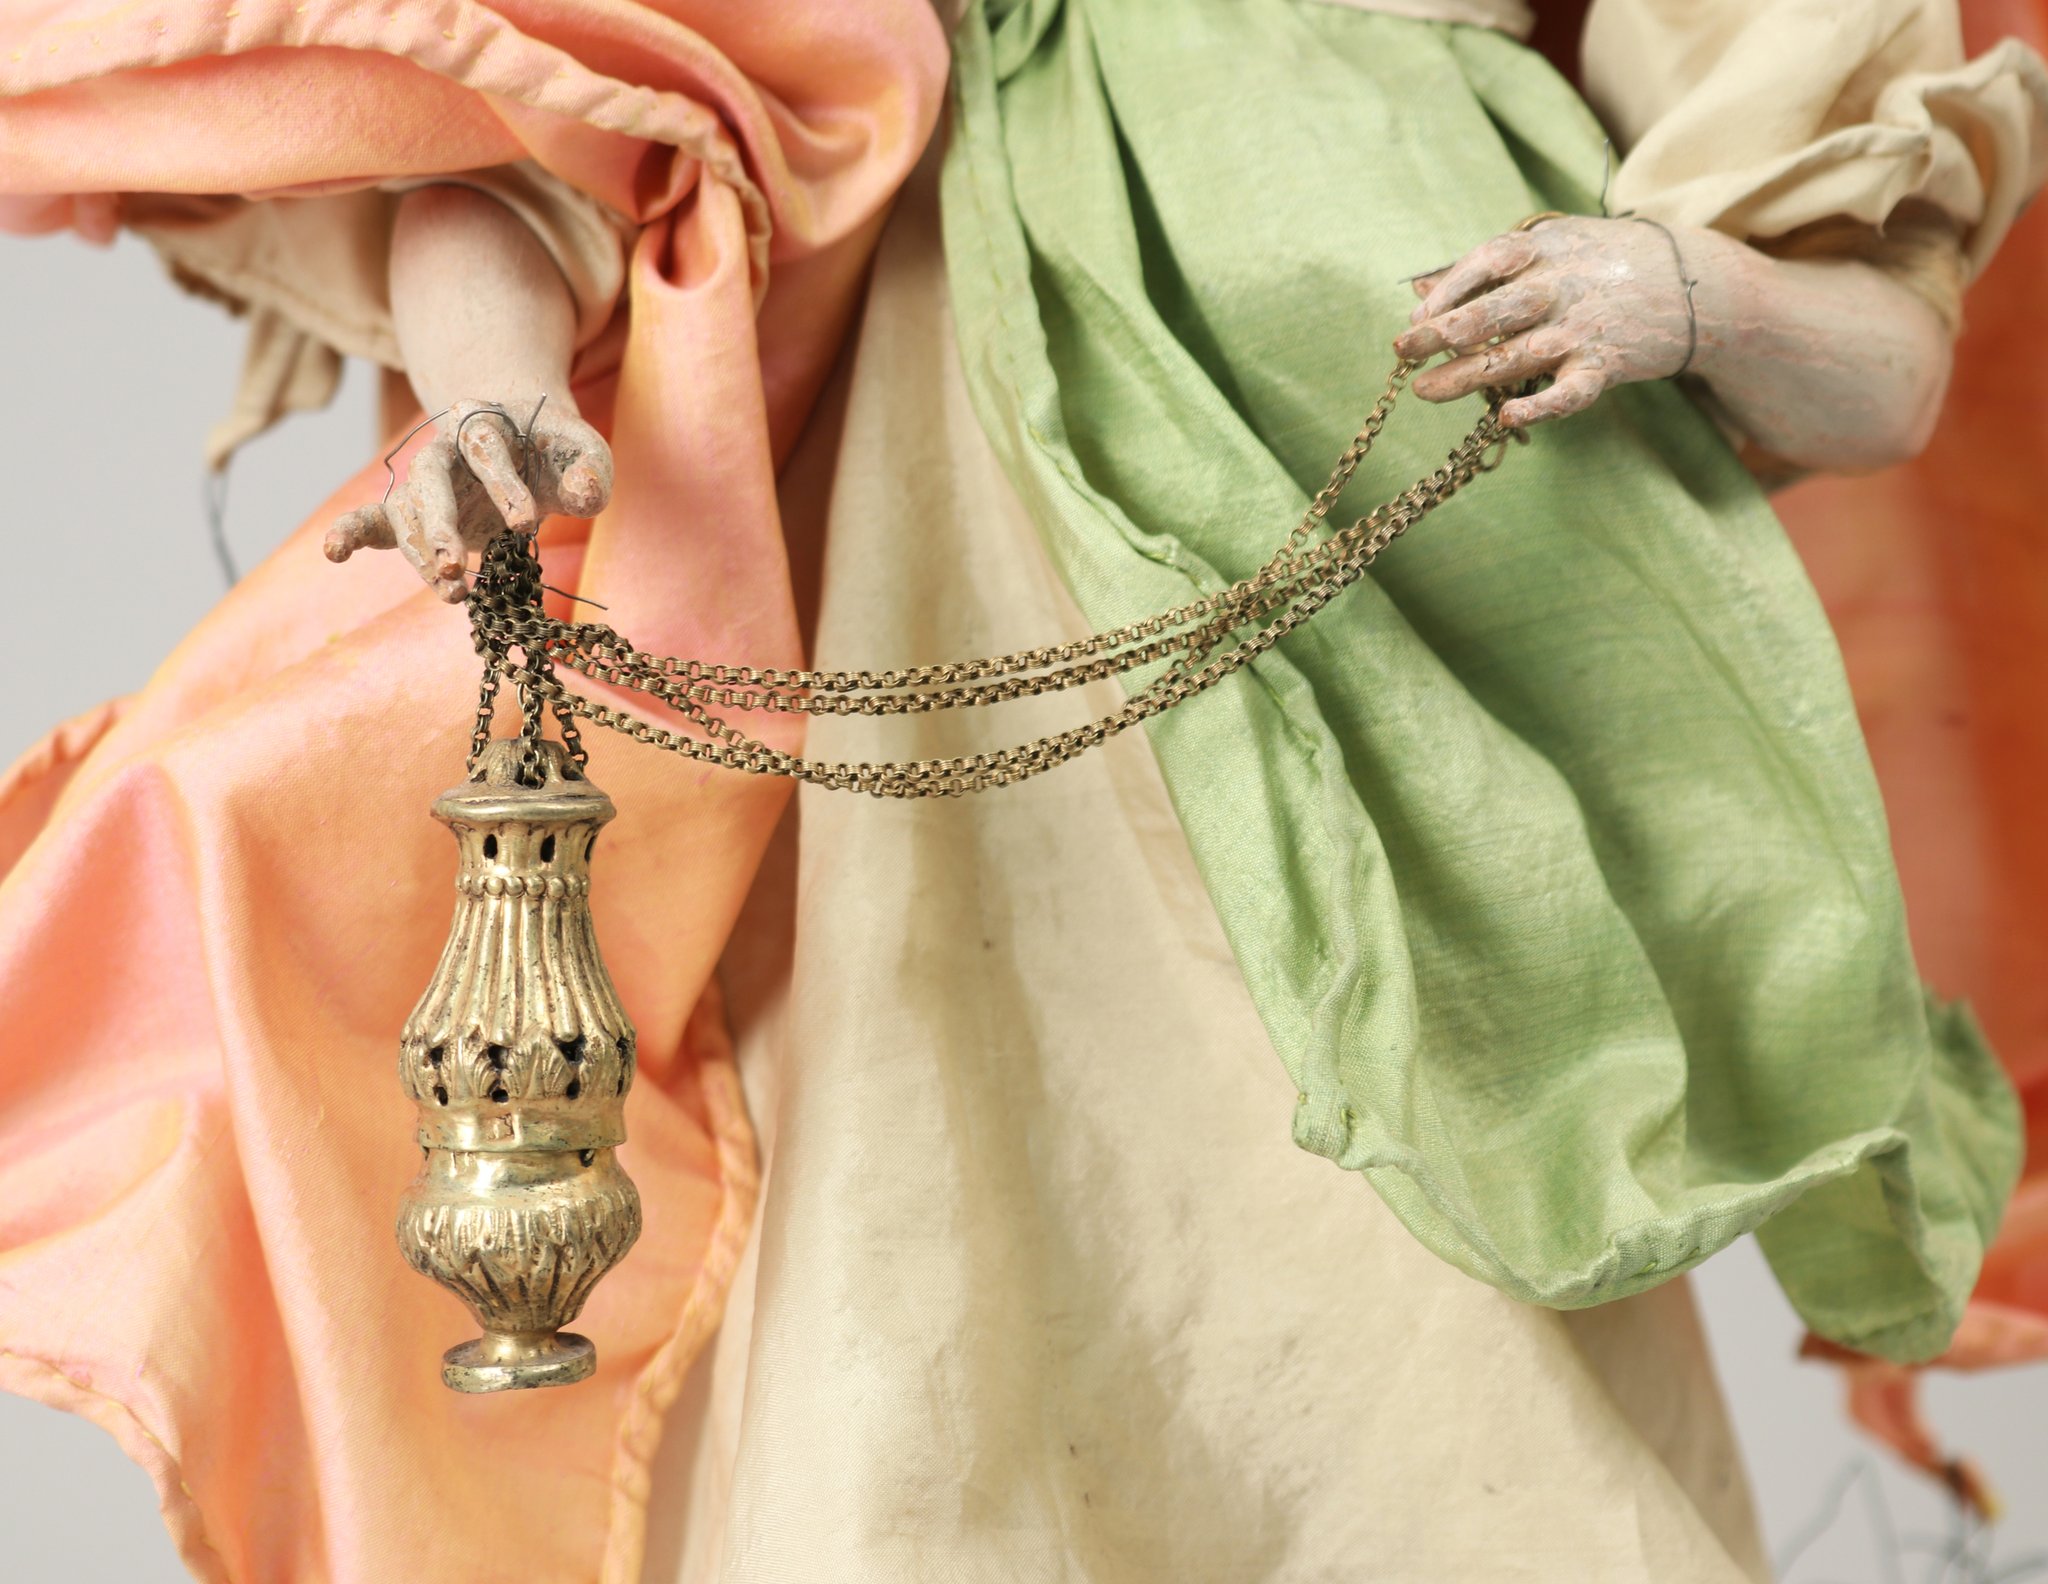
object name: crèche figure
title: Censer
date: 1751-1800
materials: silver gilt